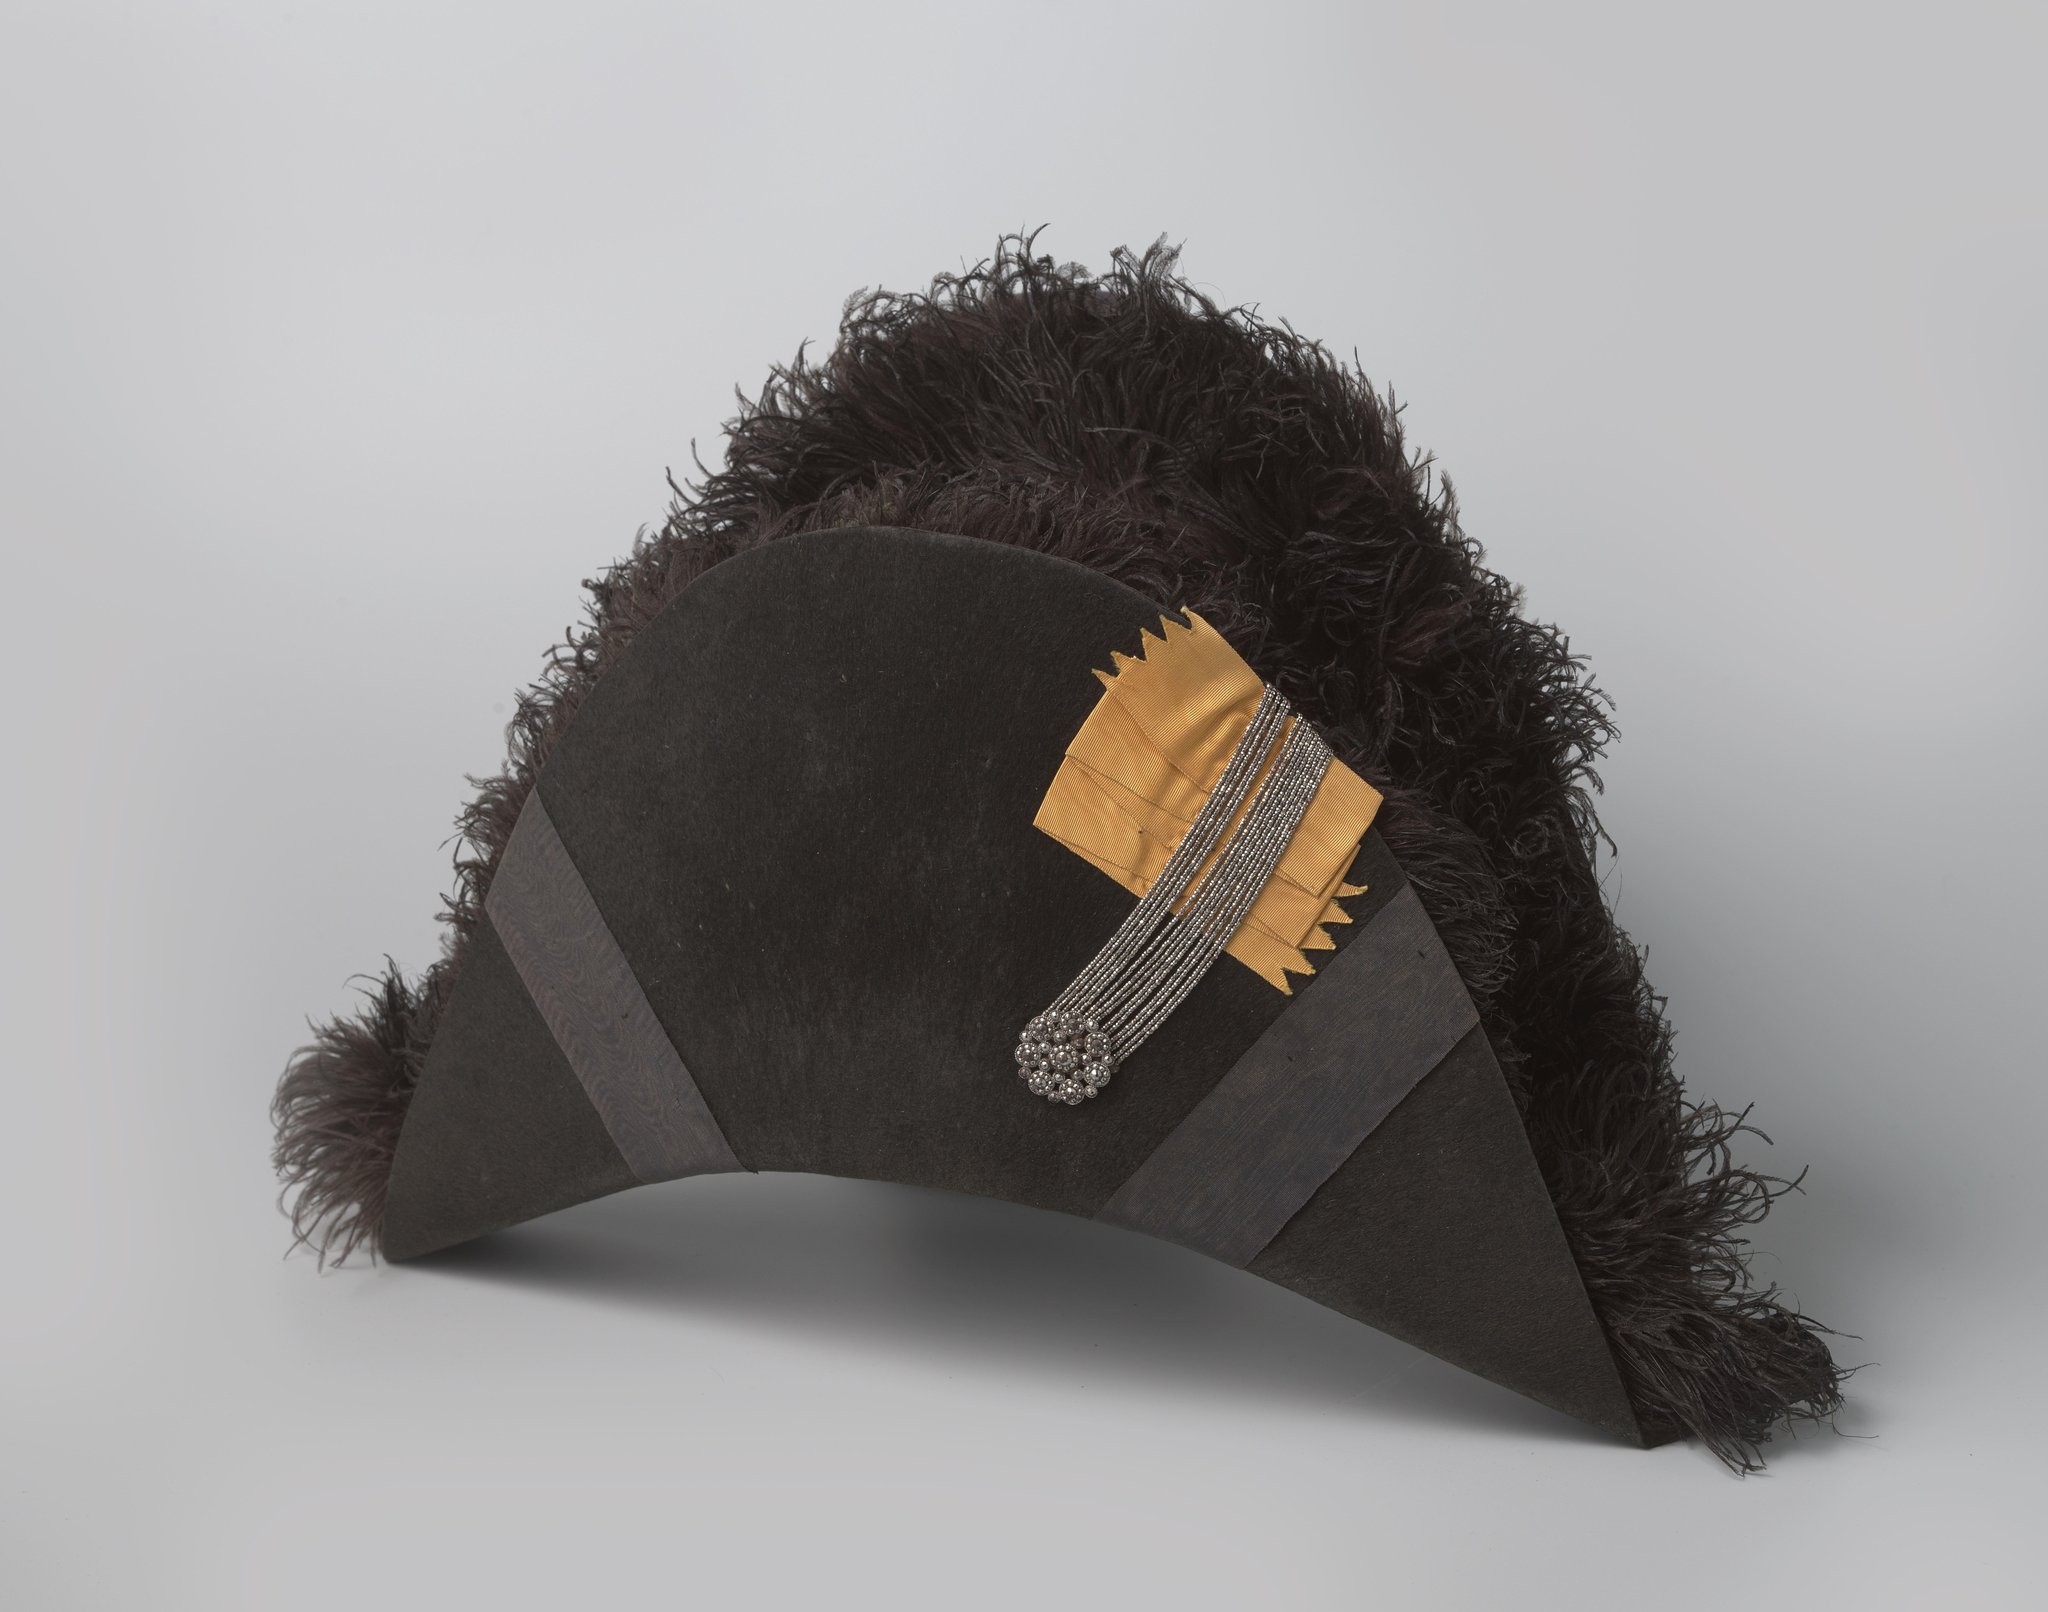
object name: menswear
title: Zwarte steek met struisveren, twee zwarte moiré-zijden linten en een versiering van stalen kralen, waaronder een oranjelint en stalen knoop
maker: Anonymous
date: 1850-1900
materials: felt, leather, silk, steel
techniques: moire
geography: western europe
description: Zwarte steek met struisveren, twee zwarte moiré-zijden linten en een versiering van stalen kralen, waaronder een oranjelint en stalen knoop. Onderdeel van heren statiekostuum.